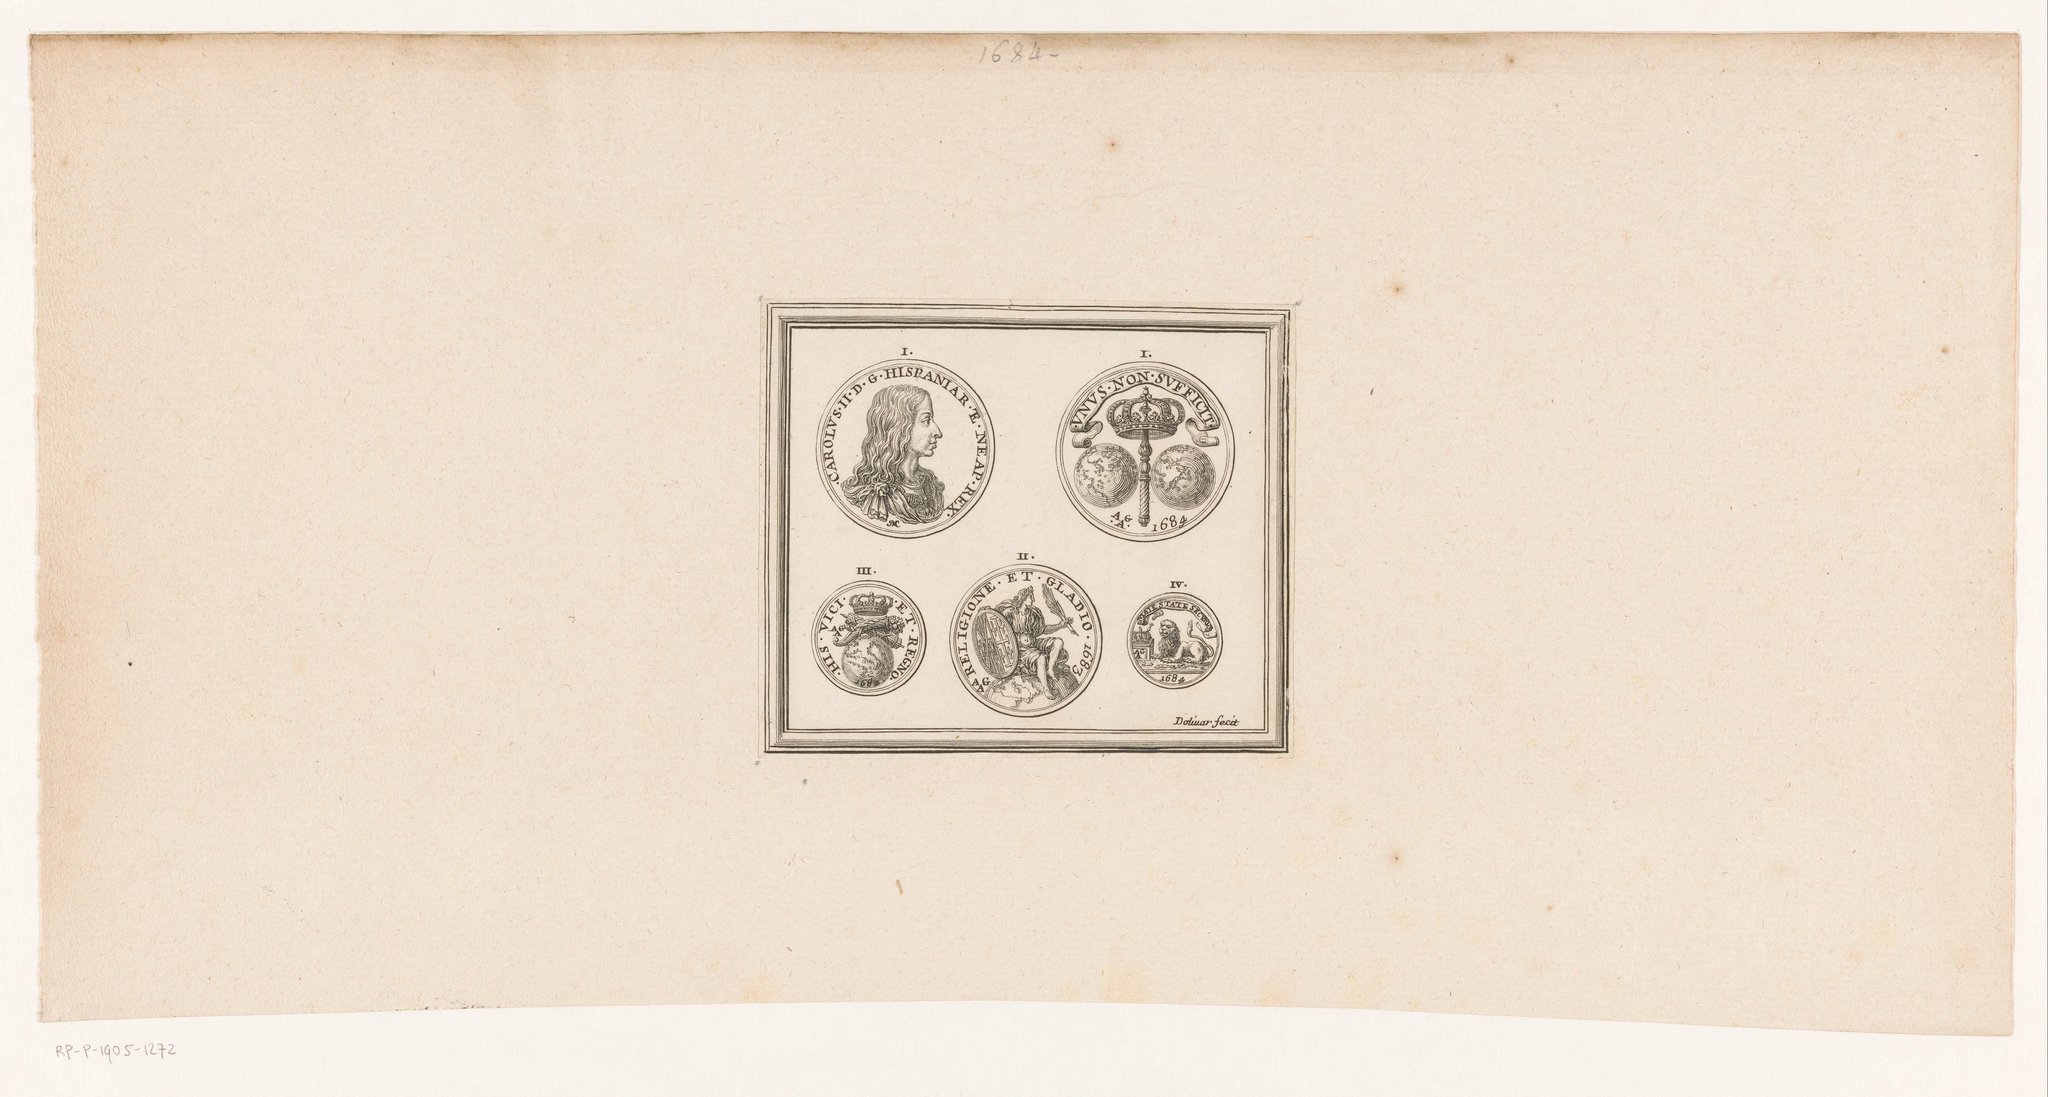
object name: print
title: Penningen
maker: juan dolívar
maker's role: print maker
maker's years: 1641-1701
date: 1684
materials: paper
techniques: etching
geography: spain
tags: karel ii (koning van spanje), historical persons, medal (considered as a piece of sculpture, regardless of its specific function), ruler, sovereign, beasts of prey, predatory animals: lion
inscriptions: collector's mark: Lugt 2228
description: Penningen waarvan één met het portret van Karel II, koning van Spanje.